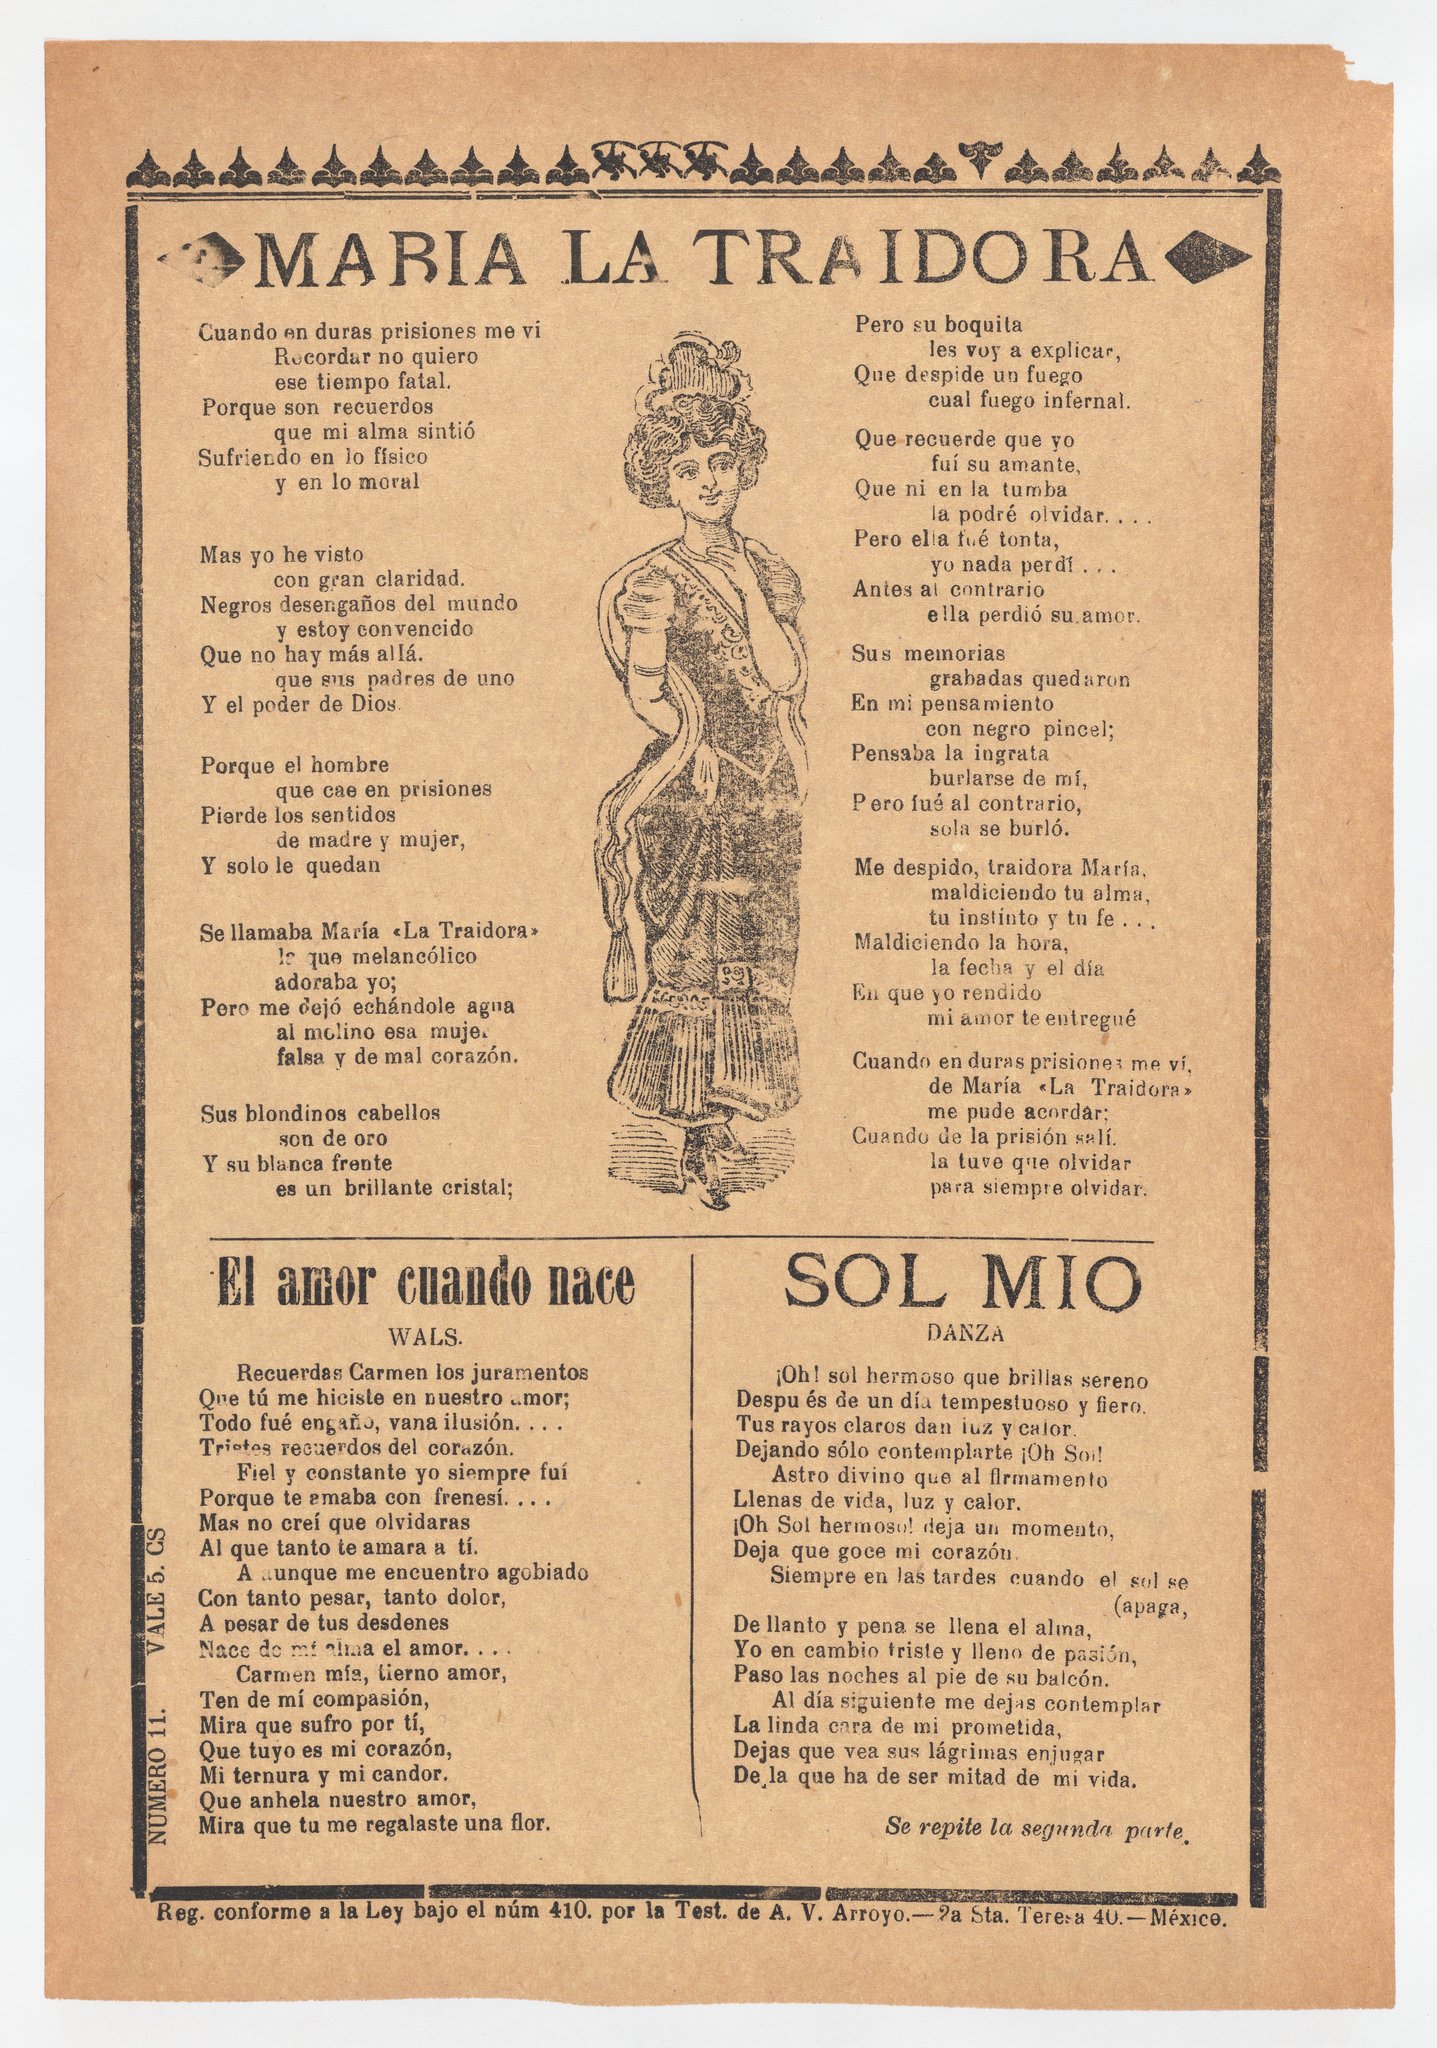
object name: print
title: Broadsheet with three ballads about love, a woman wearing a dress and hat placing one hand to her chest and the other behind her back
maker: josé guadalupe posada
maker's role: artist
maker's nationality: mexican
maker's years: 1852-1913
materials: paper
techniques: letterpress, lithography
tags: women